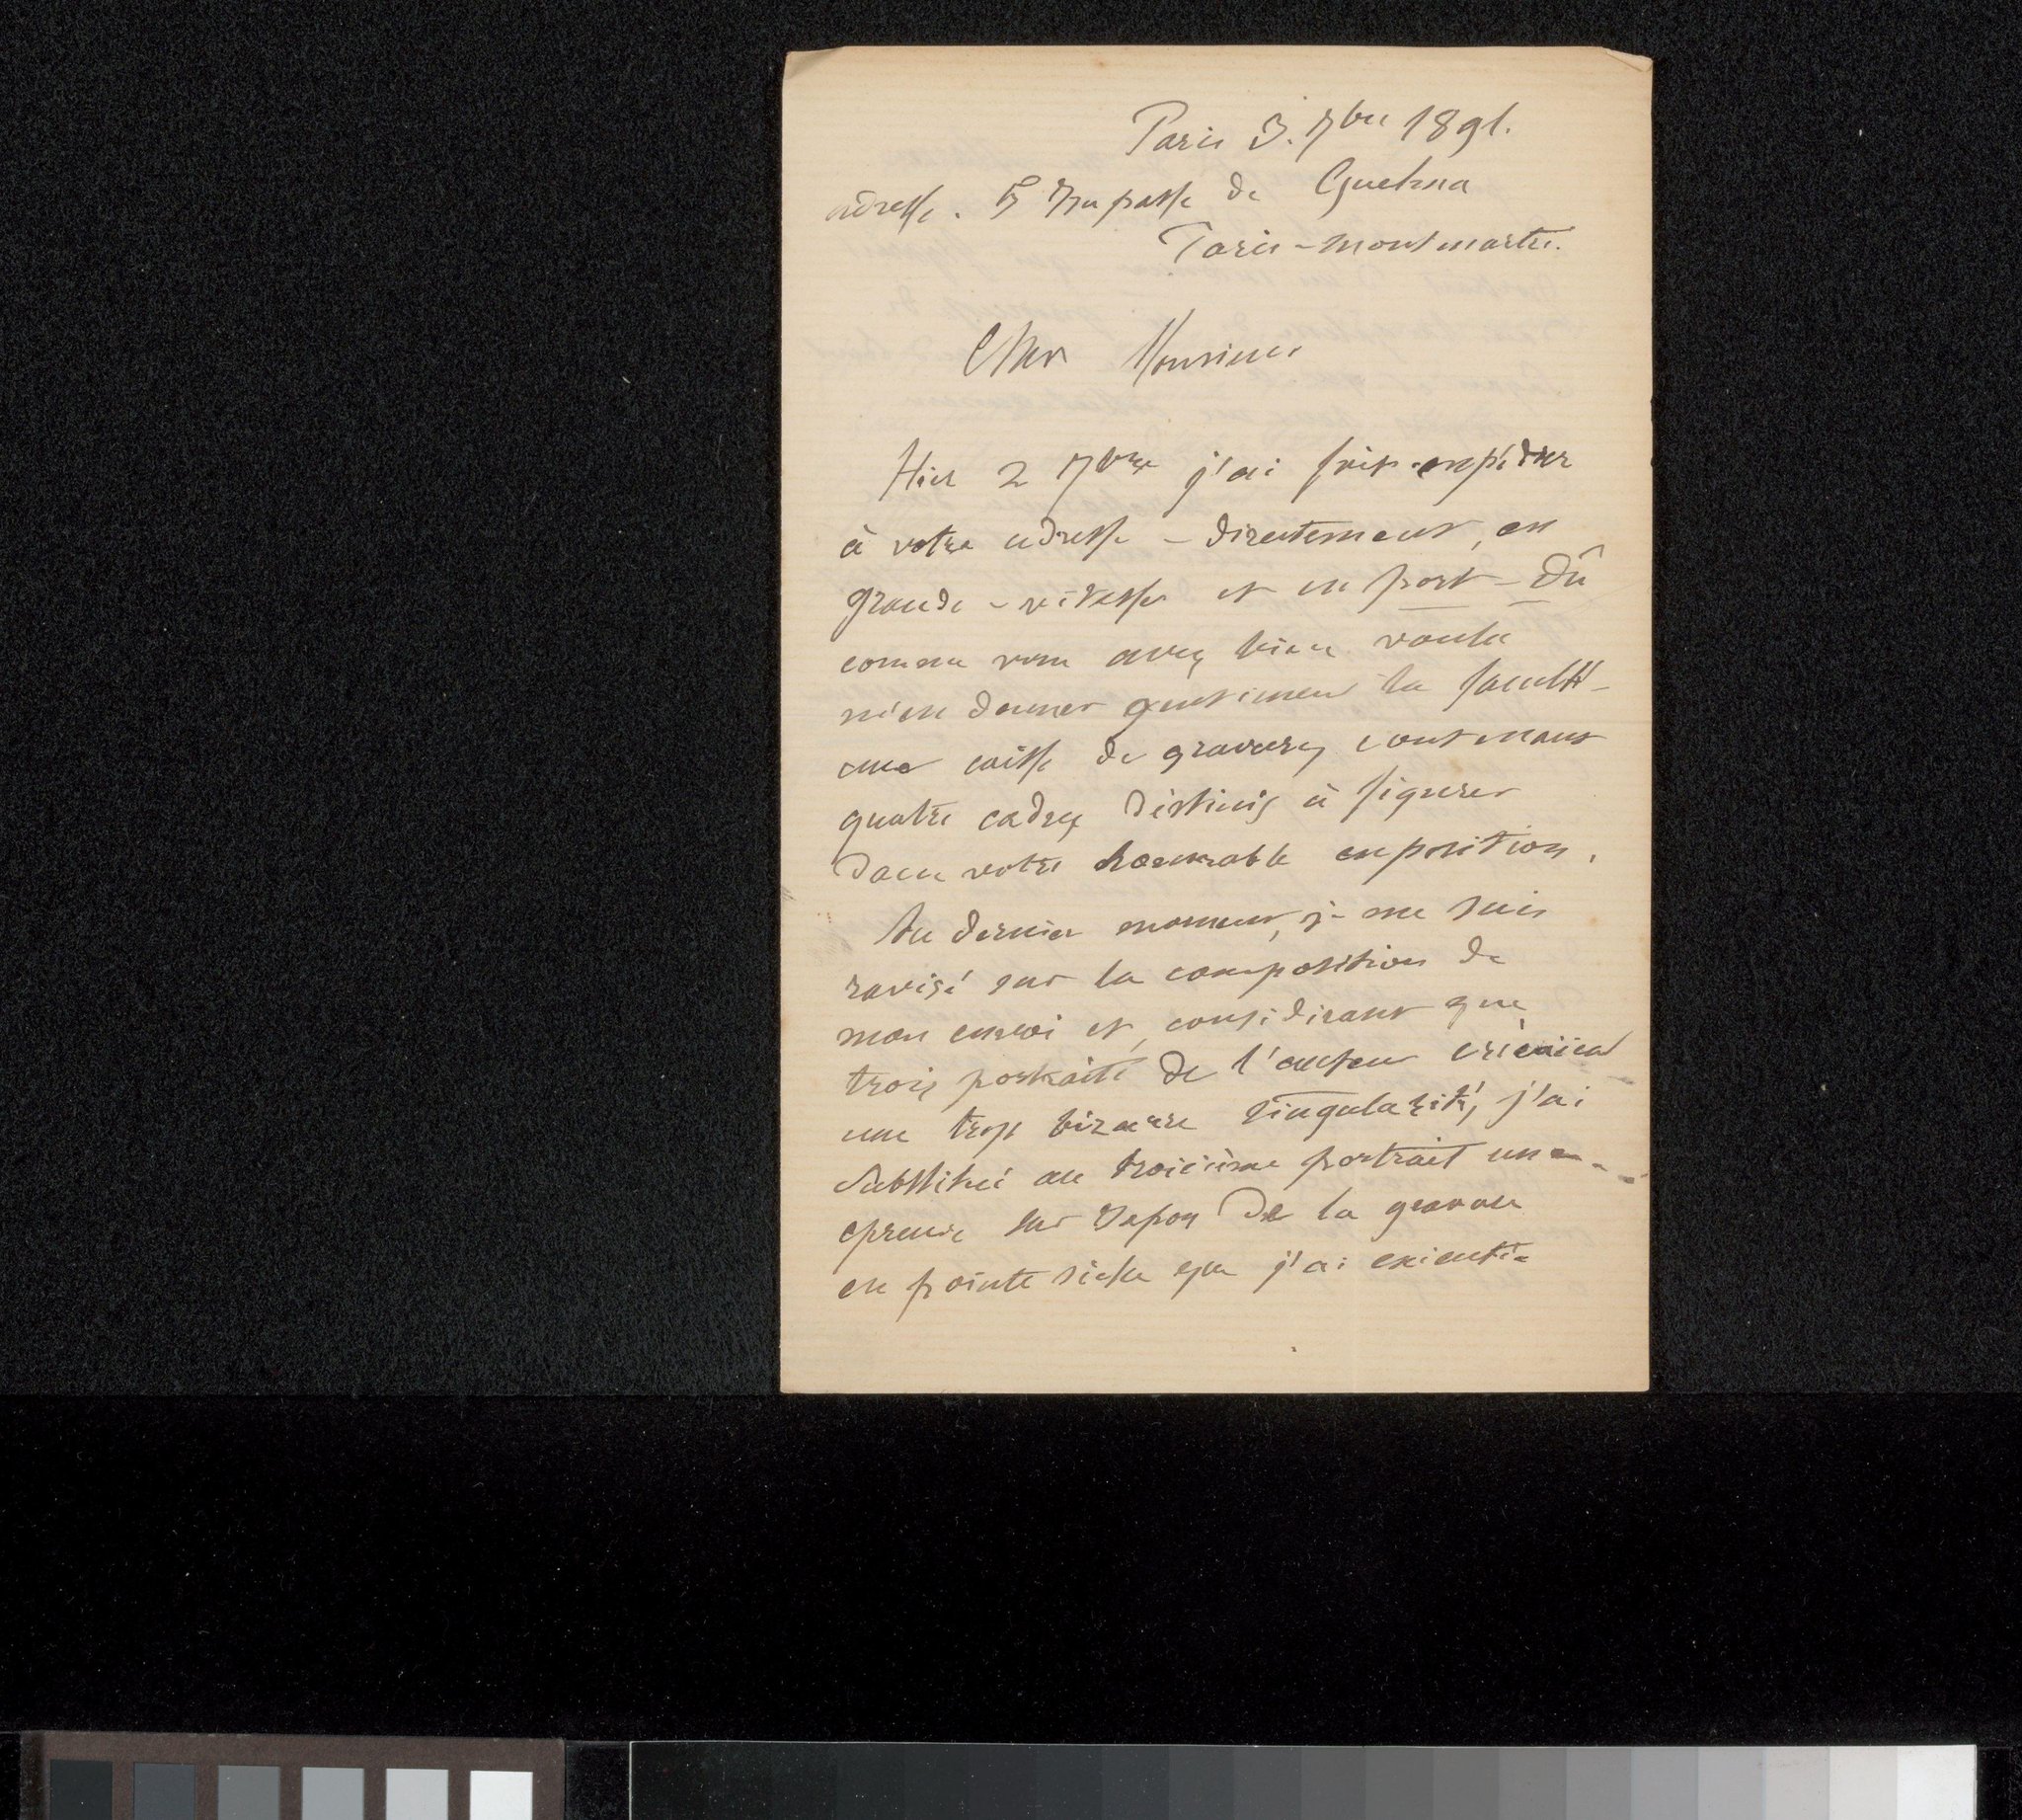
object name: letter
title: Brief aan Philip Zilcken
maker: marcellin gilbert desboutin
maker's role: print maker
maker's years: 1823-1902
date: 1891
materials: ink, paper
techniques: pen, writing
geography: paris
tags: painter, draughtsman, philip zilcken, the graphic arts, exhibition ~ art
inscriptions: collector's mark: ‘RPK’